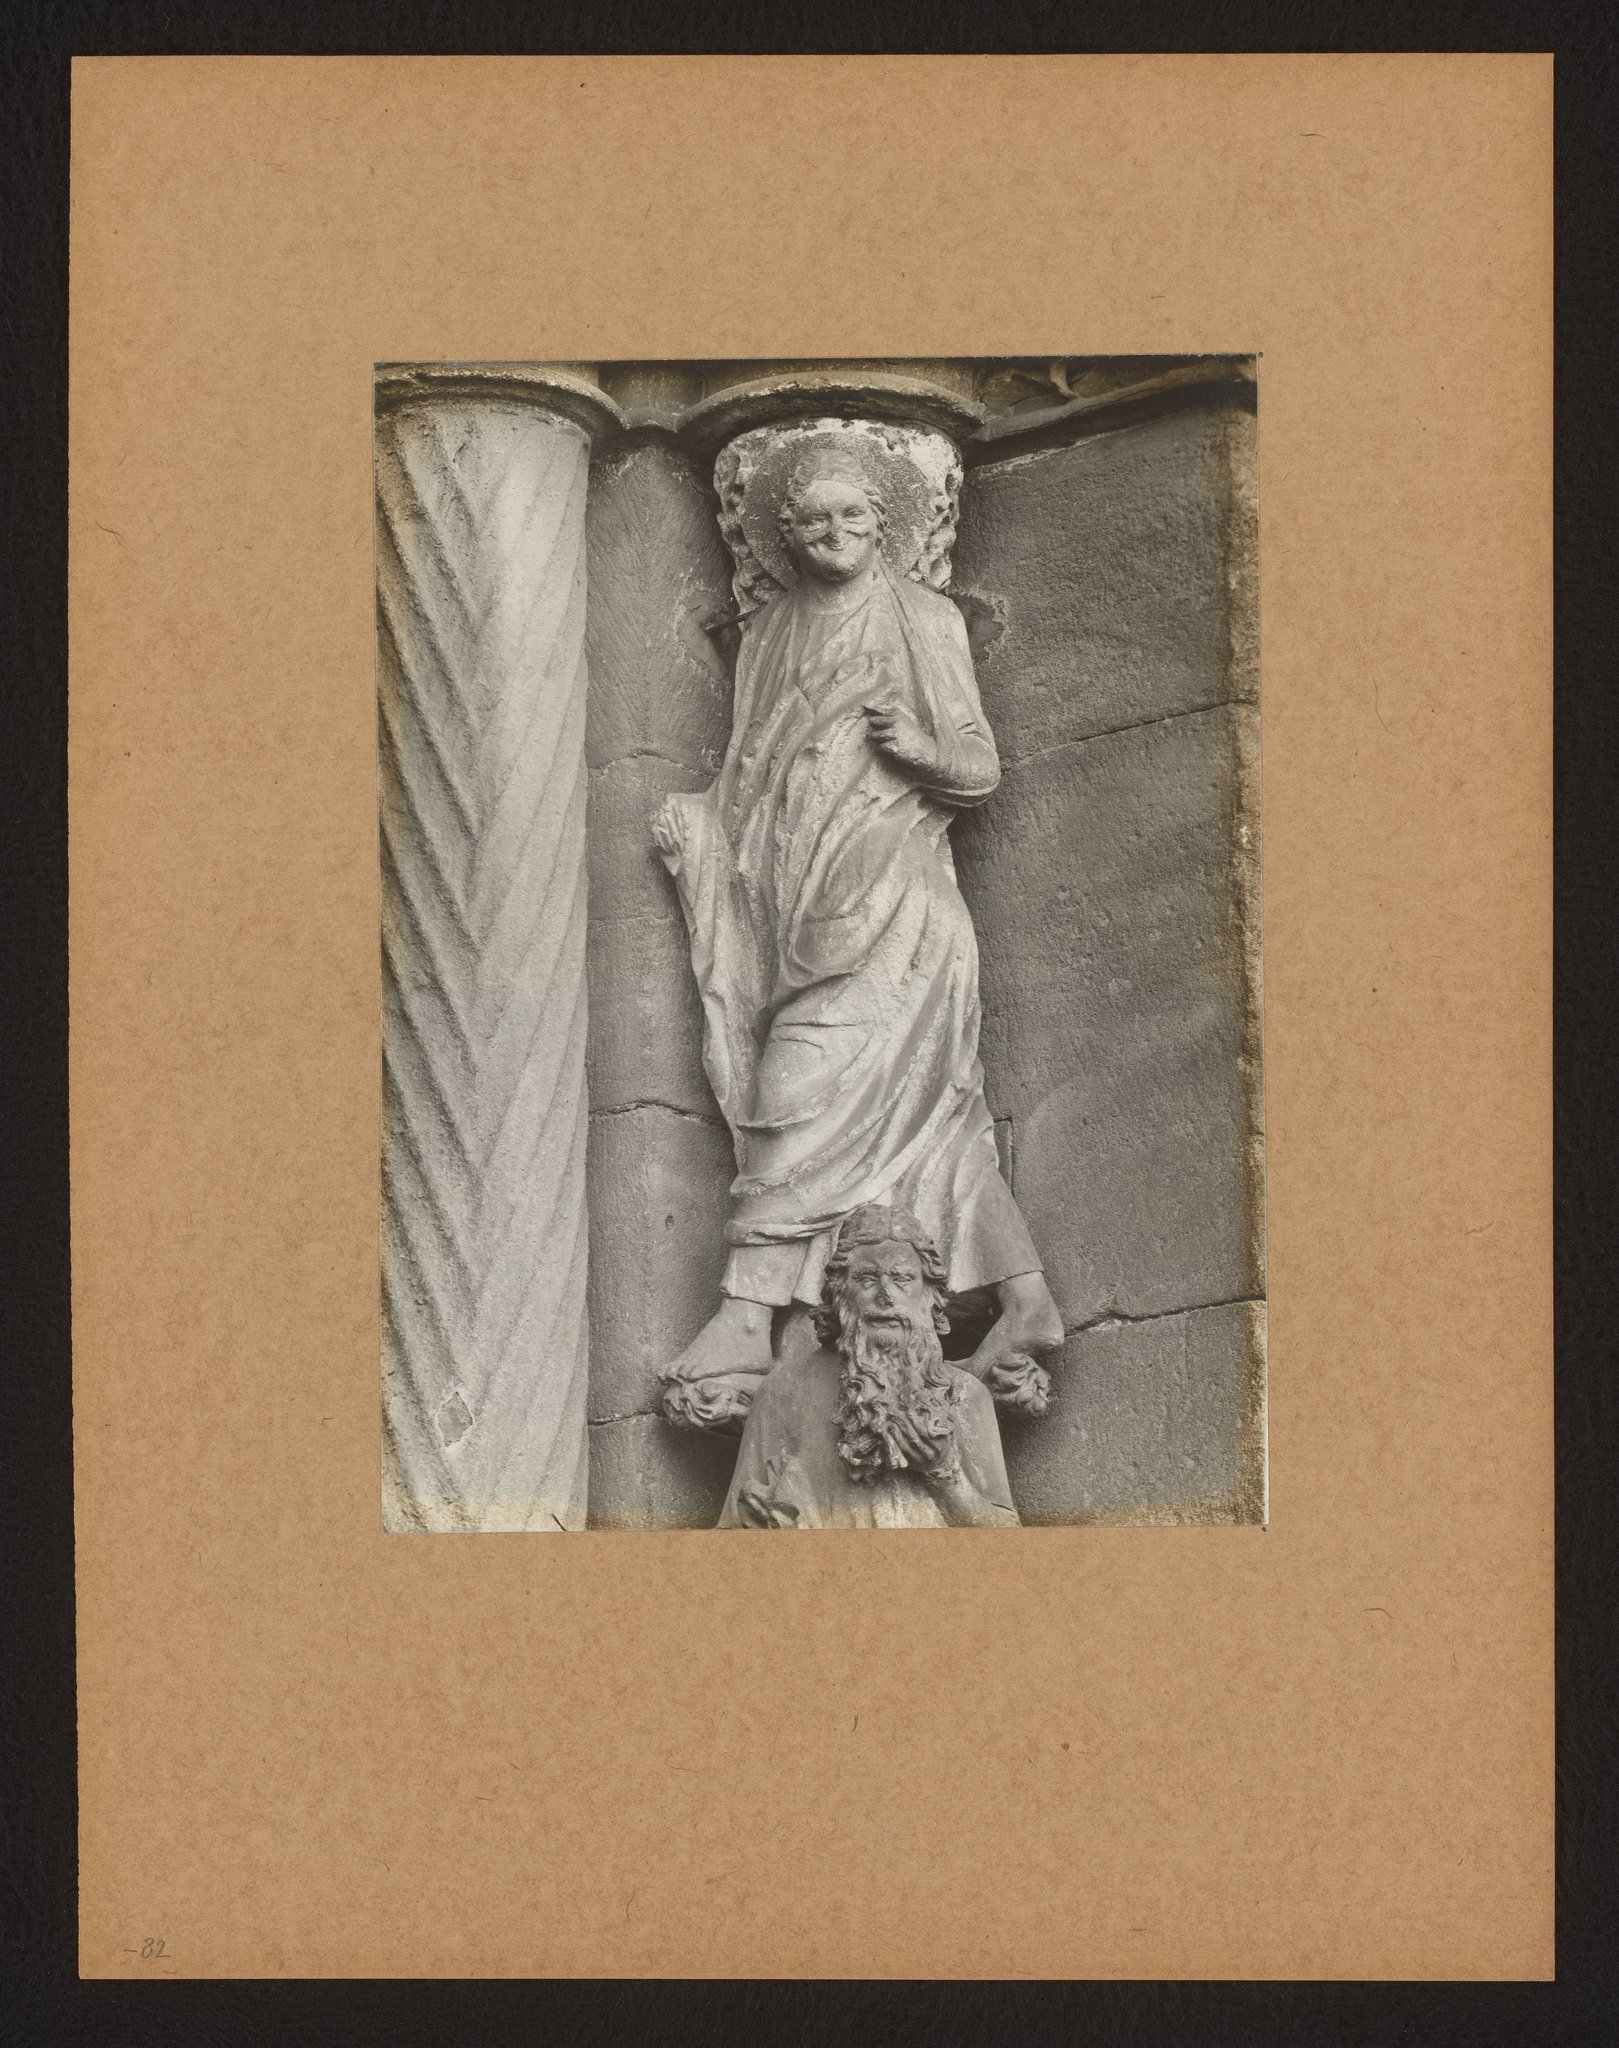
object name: album leaf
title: Beeldhouwwerk aan de dom van Bamberg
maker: Anonymous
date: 1900-1920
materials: paper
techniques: gelatin silver print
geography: bamberg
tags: church (exterior)